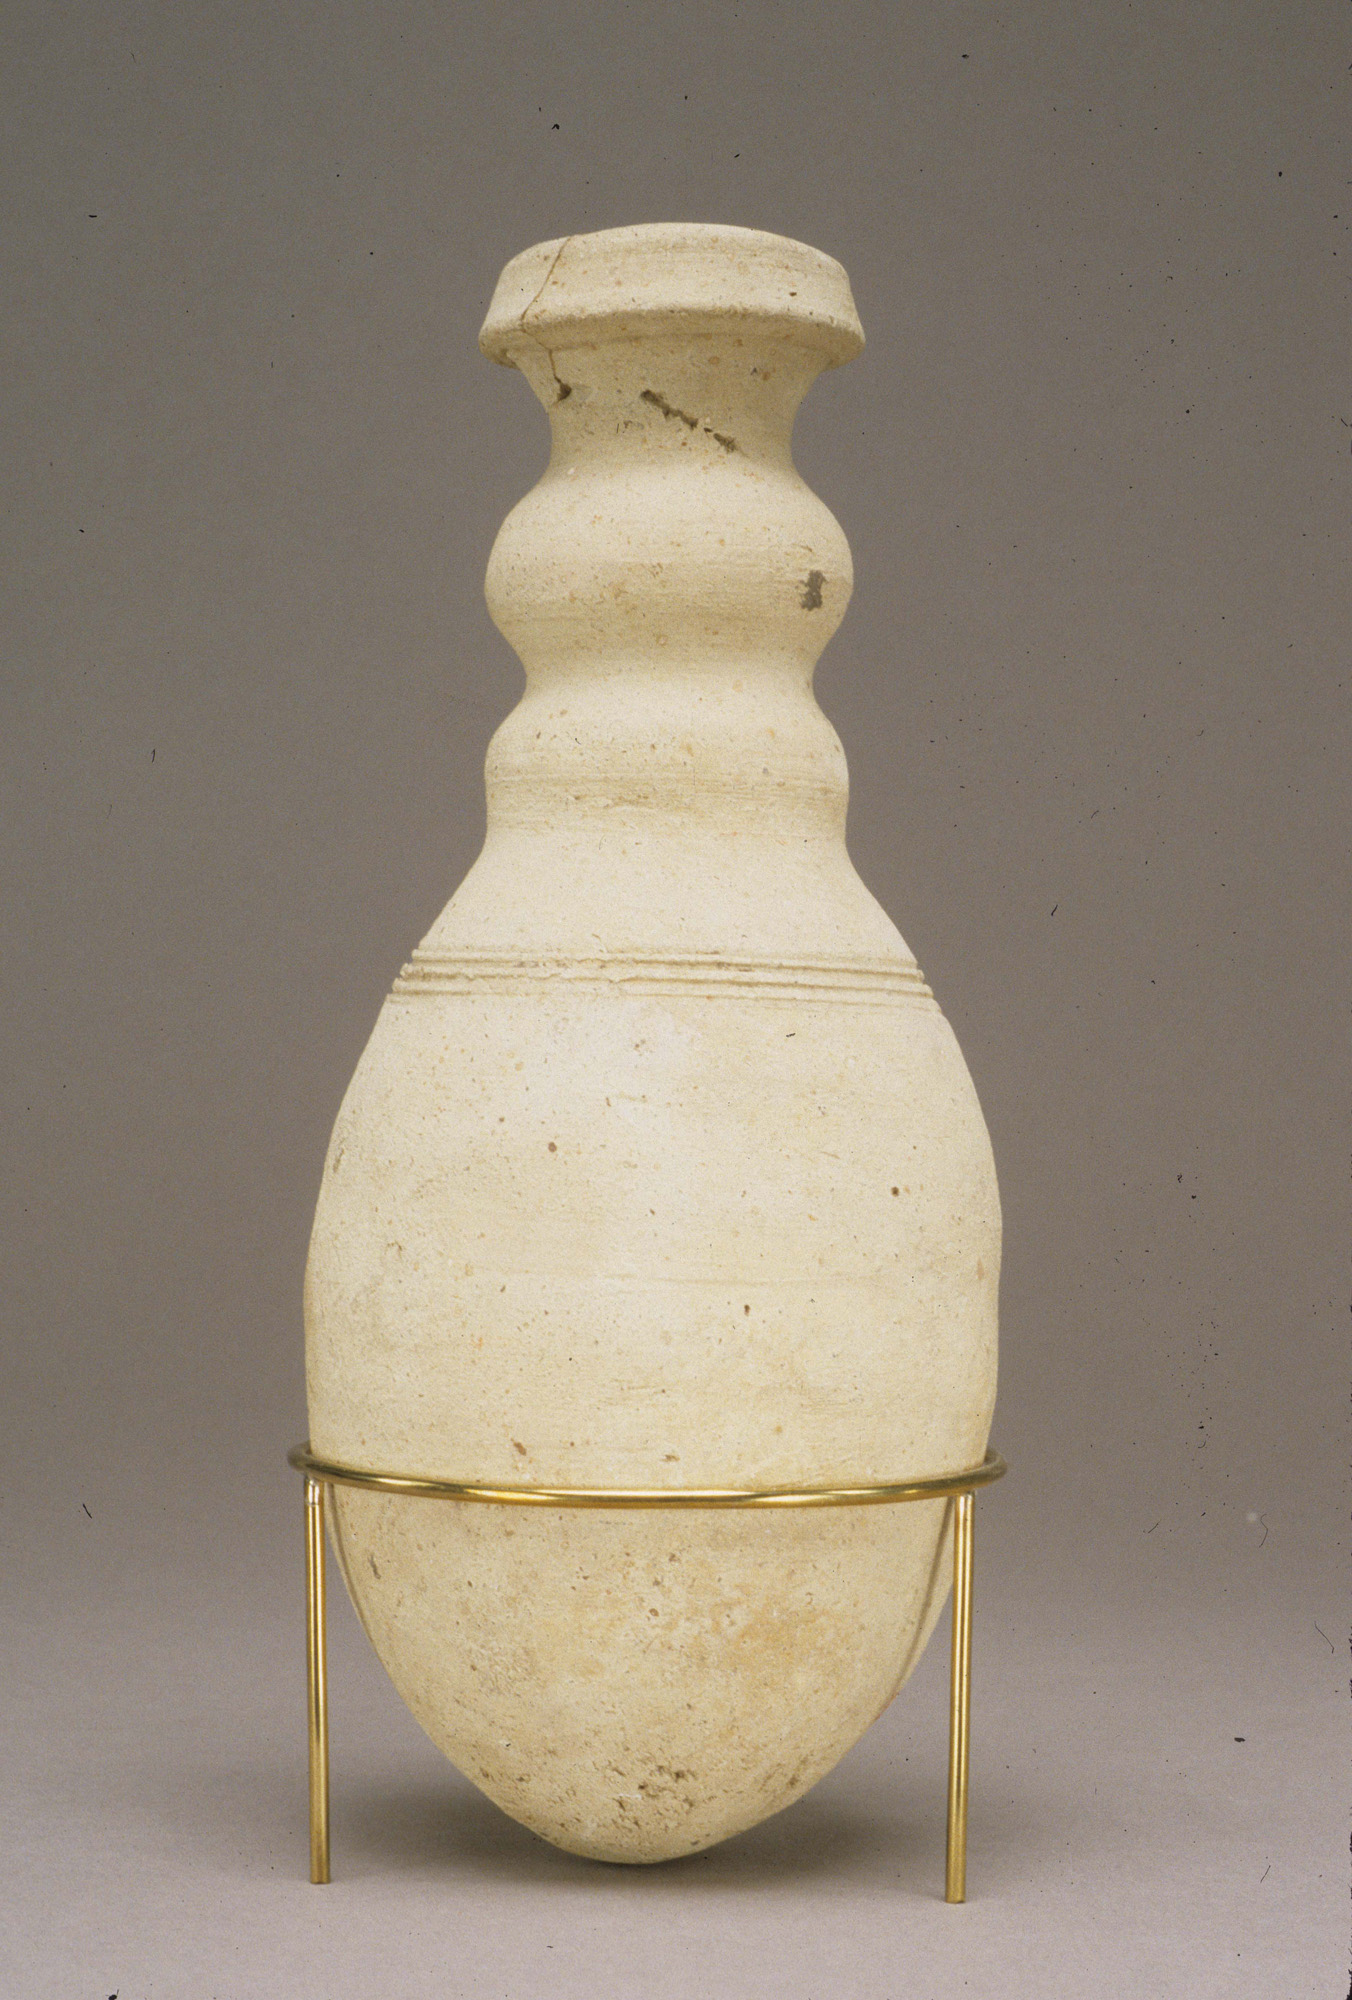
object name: jar, bottle necked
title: Bottle-necked jar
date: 2030-1640 BCE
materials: pottery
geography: egypt